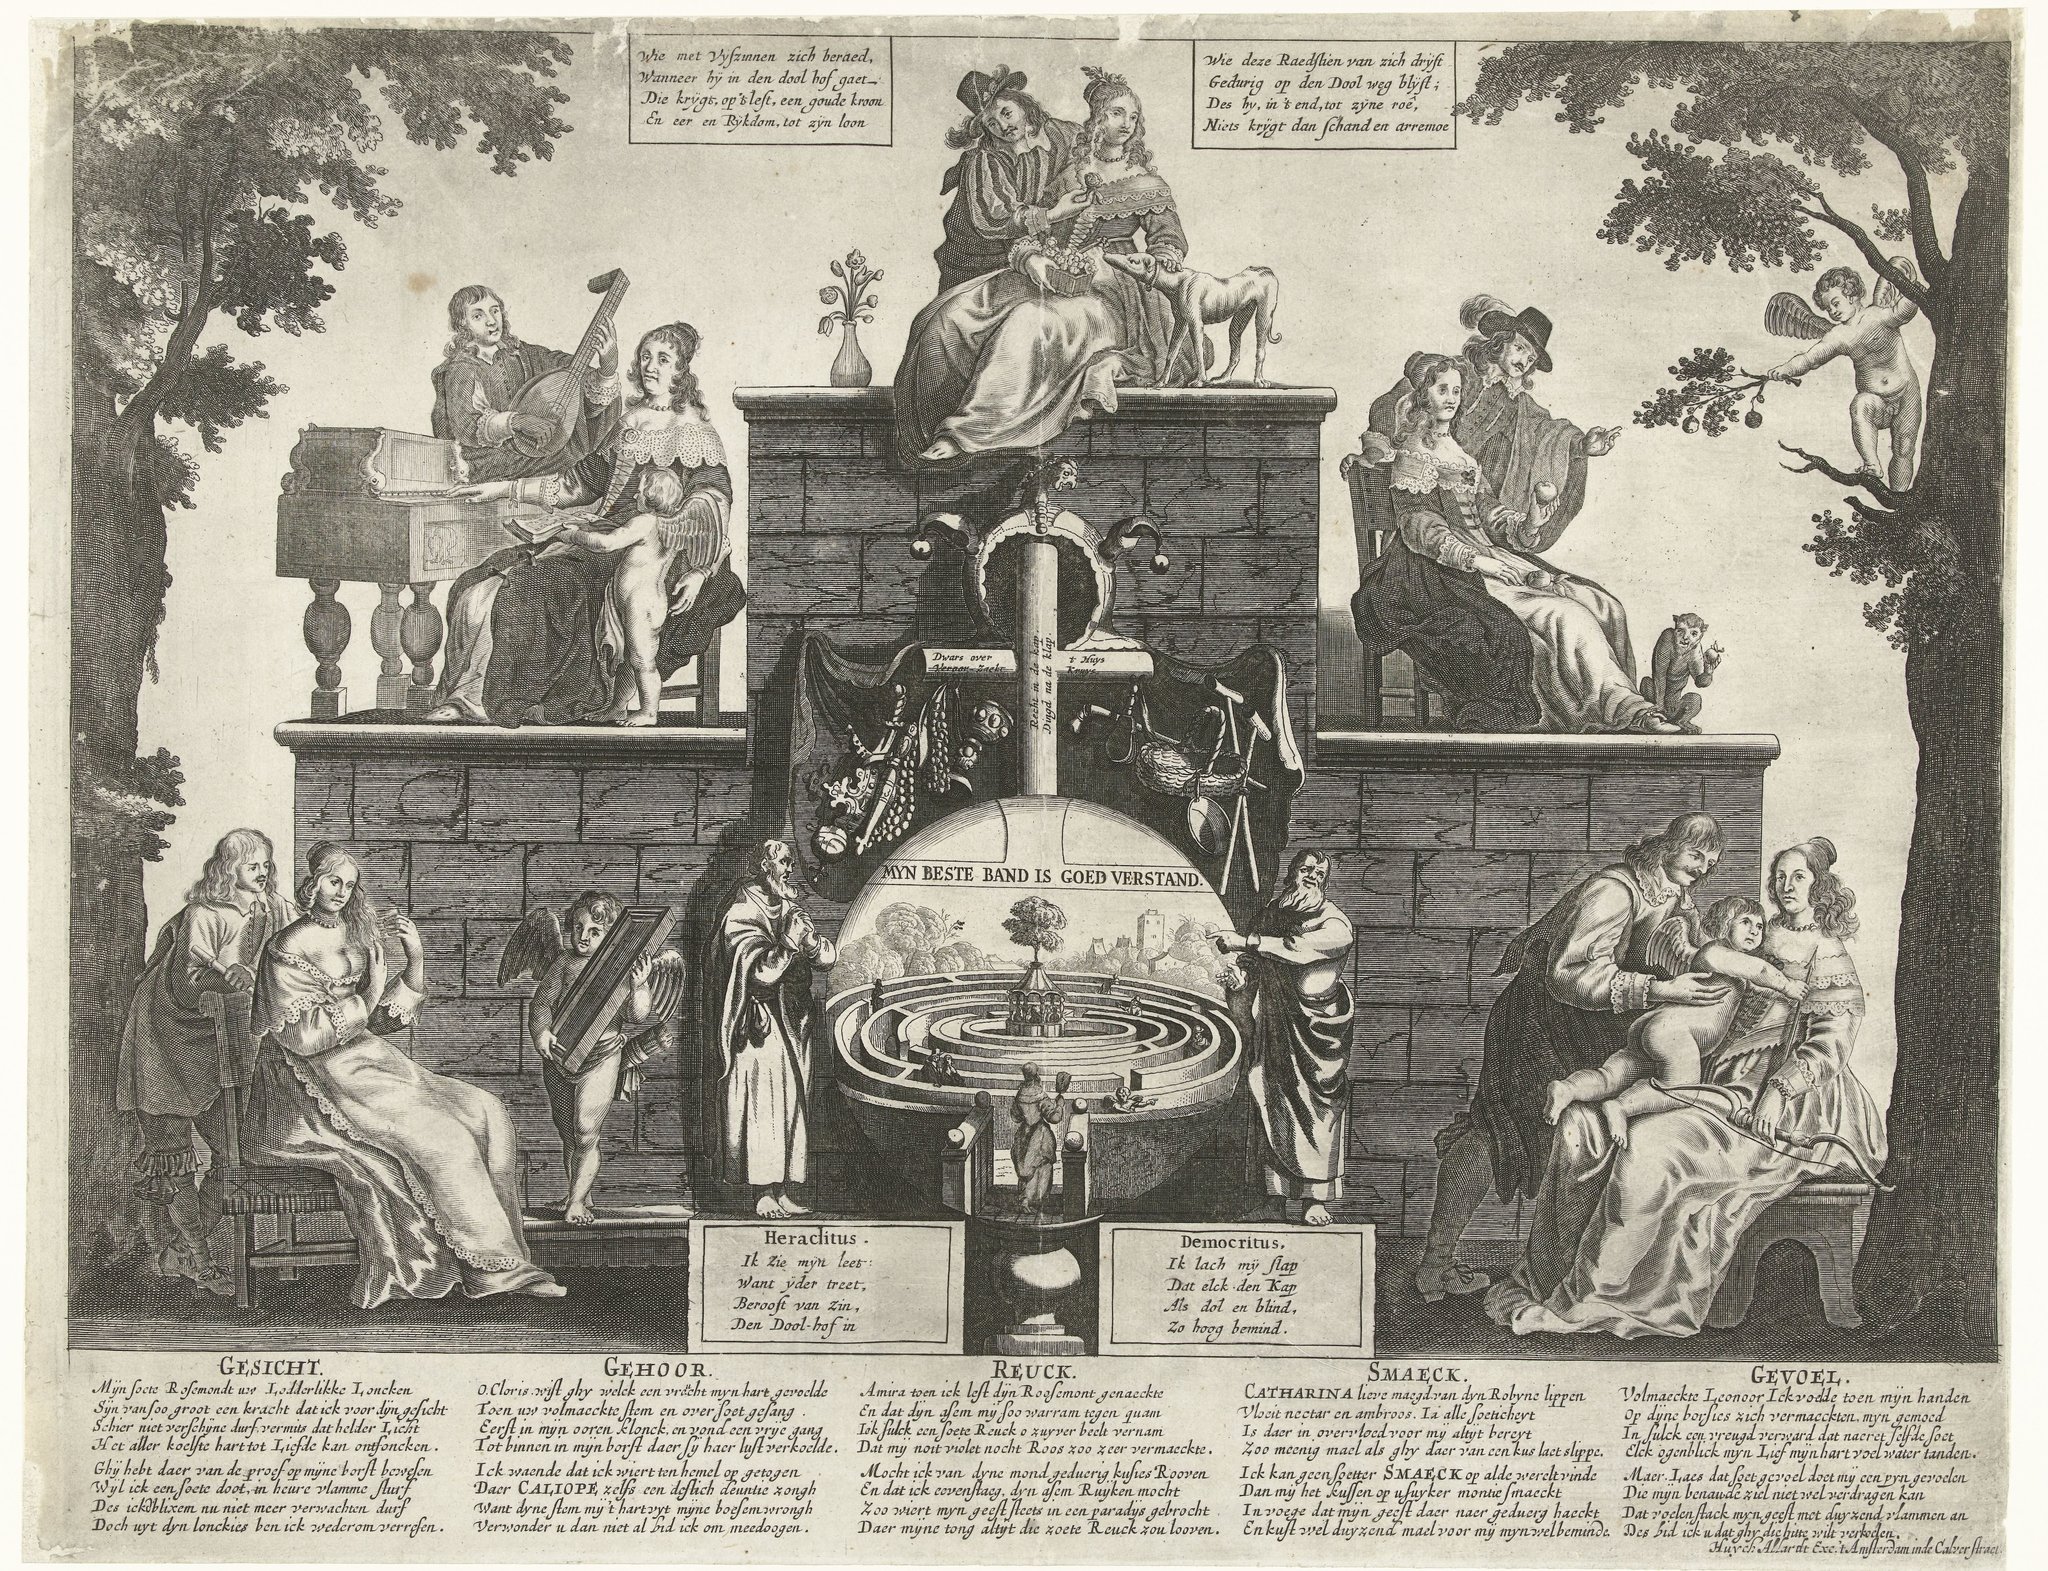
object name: print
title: Allegorie op het doolhof van het menselijk onverstand, ca. 1650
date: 1640-1660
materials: paper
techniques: engraving, etching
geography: northern netherlands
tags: the (five) senses, labyrinth, maze ~ garden, couple of lovers, heraclitus, the weeping philosopher, and democritus, the laughing philosopher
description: Allegorie op het doolhof van het menselijk onverstand, ca. 1650. Trapvormig bouwwerk met op de vijf trappen liefdesparen die de vijf zintuigen voorstellen. In het midden de wereldbol, waarop een doolhof is afgebeeld. Daarboven een kruis met een narrenkap, rechts en links Democritus en Heraclites. In het onderschrift 5 verzen van 8 regels.